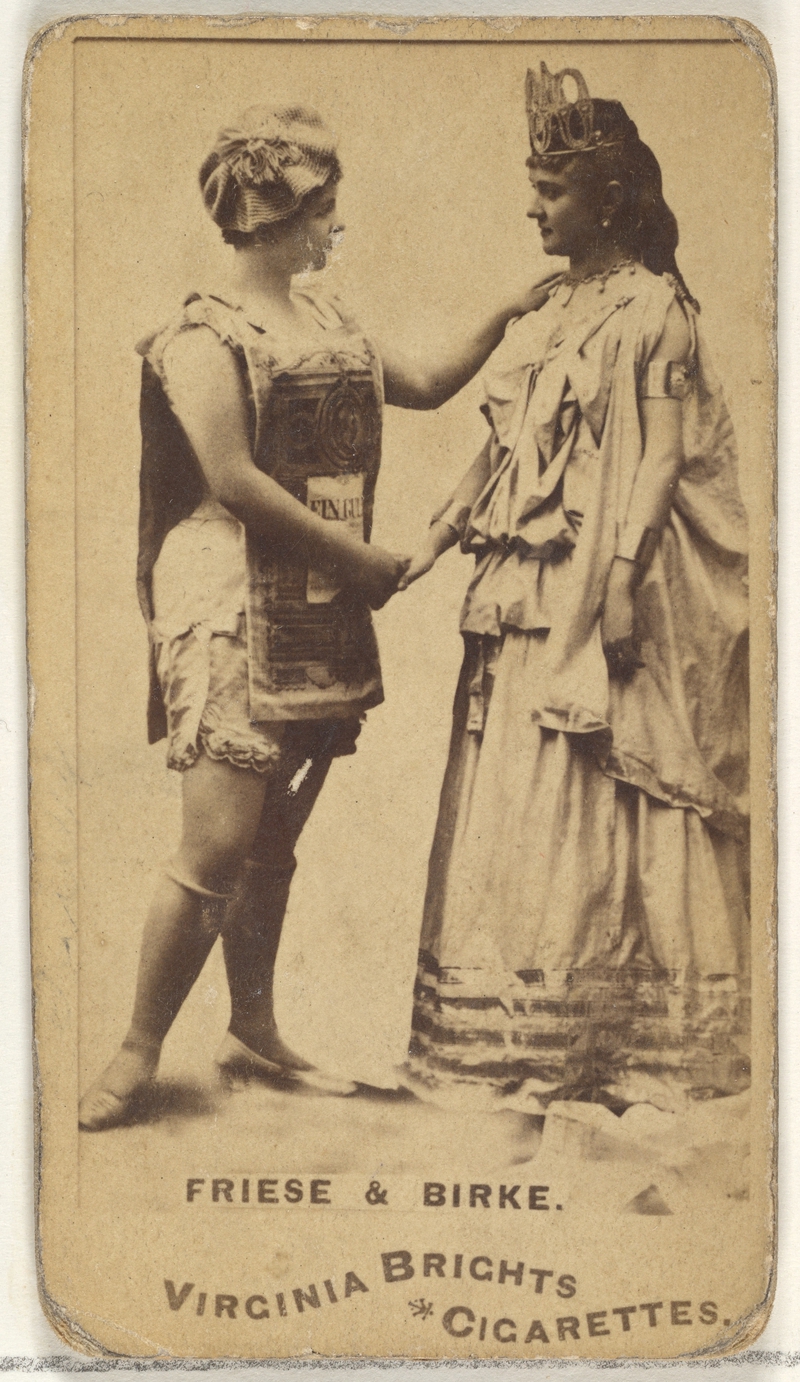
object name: photograph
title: Friese & Birke, from the Actors and Actresses series (N45, Type 1) for Virginia Brights Cigarettes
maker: allen & ginter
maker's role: publisher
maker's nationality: american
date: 1888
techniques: albumen silver print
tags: portraits,women,actresses